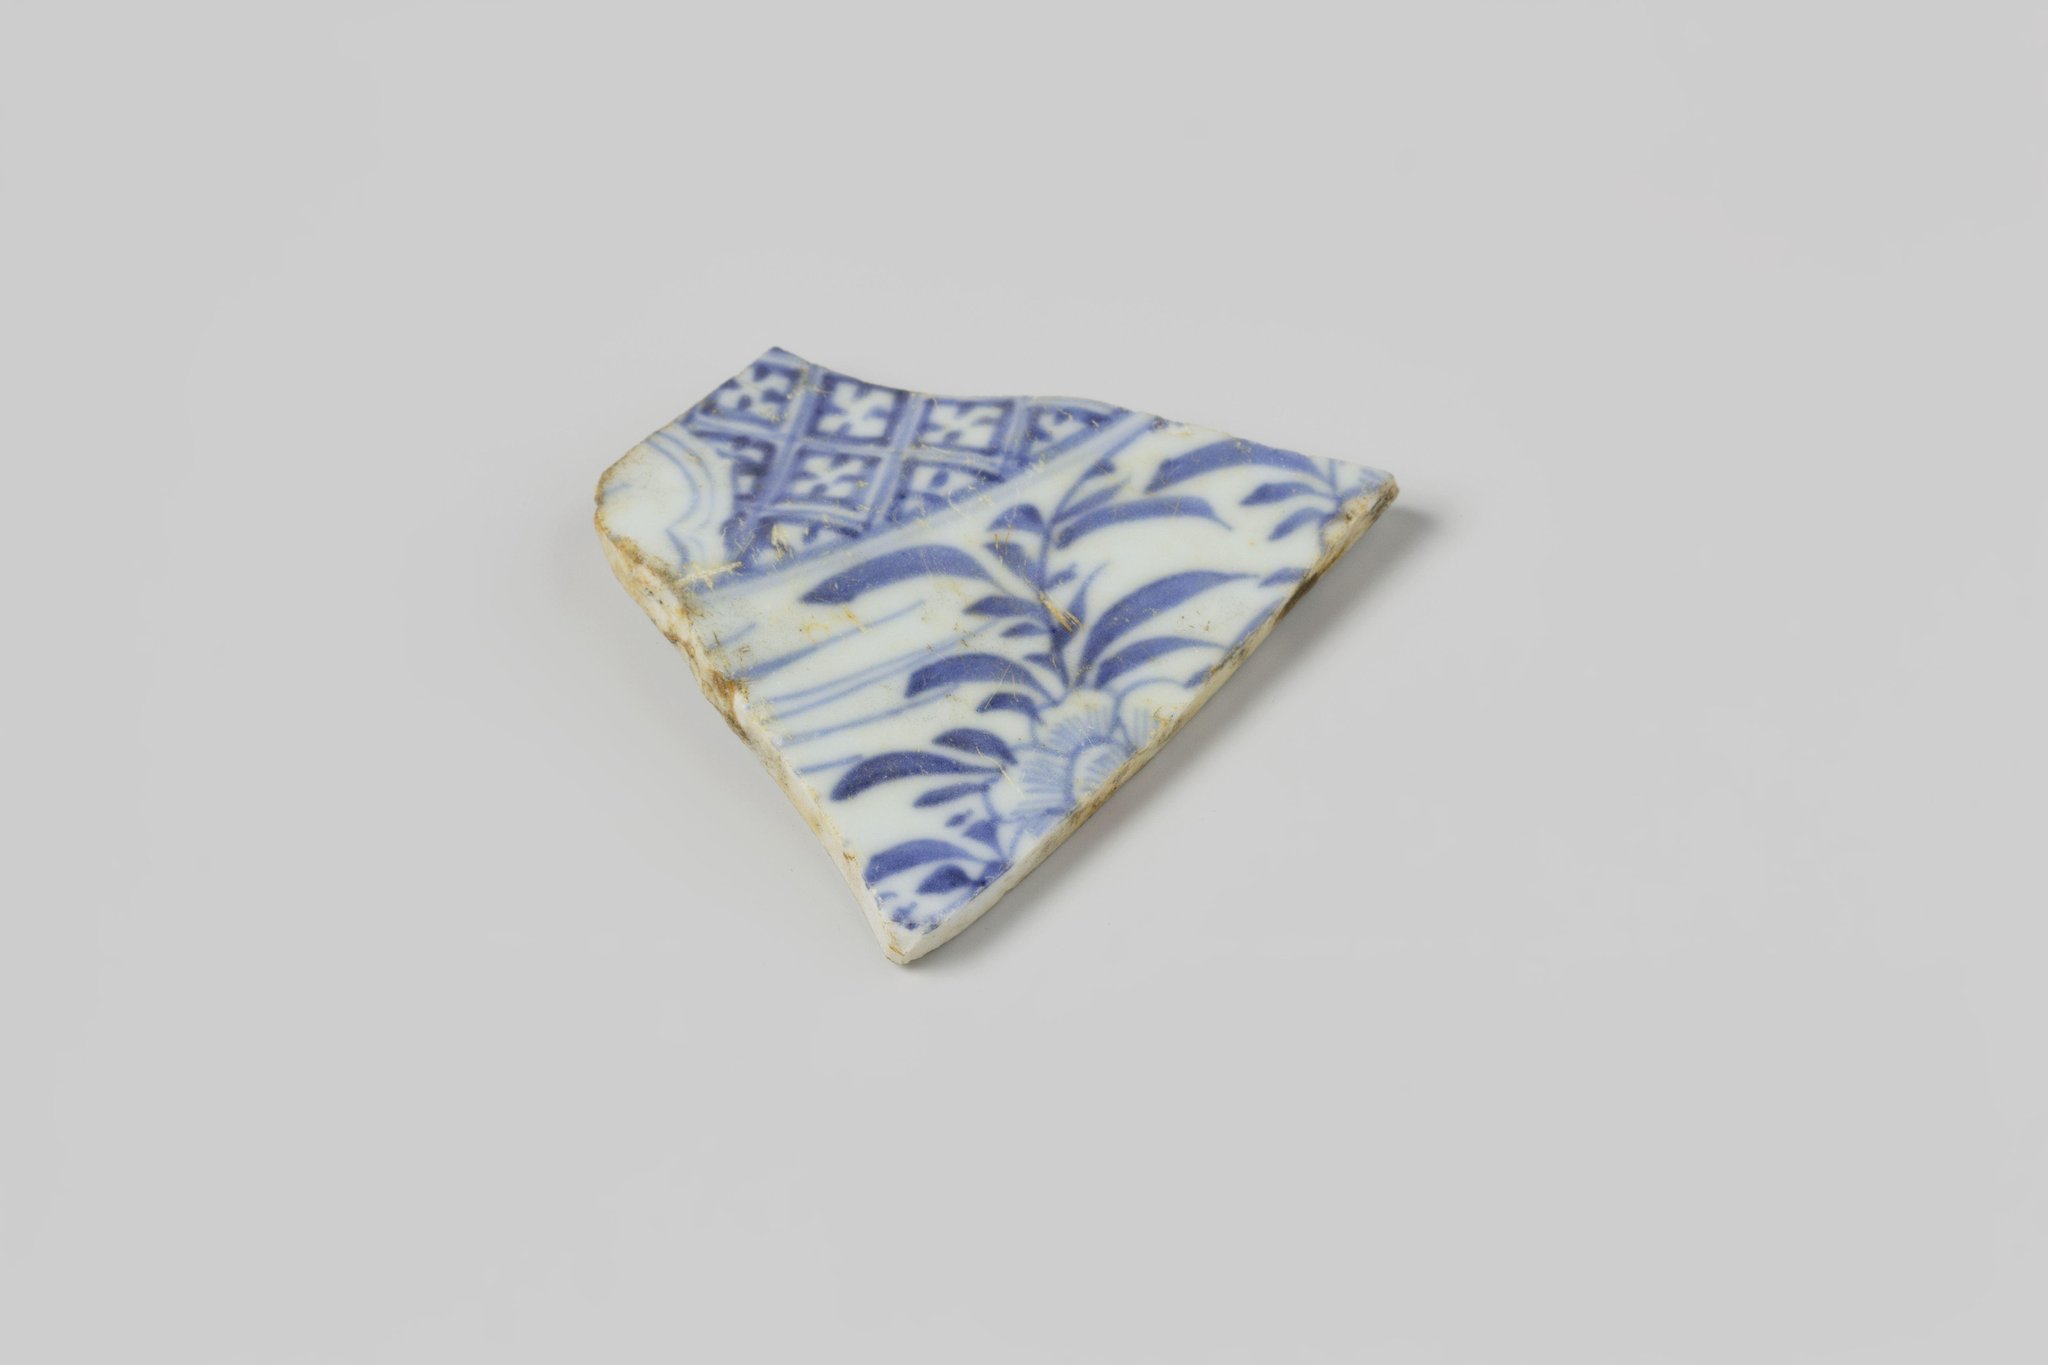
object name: plate dish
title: Scherf van een bord uit het wrak van de Oost-Indiëvaarder Hollandia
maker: Anonymous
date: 1700-1743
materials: porcelain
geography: netherlands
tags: verenigde oostindische compagnie, hollandia (schip), annet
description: Porcelain, plate, type 2; fragm of rim with cavetto, sim. NG 1980-27H507/2624h.